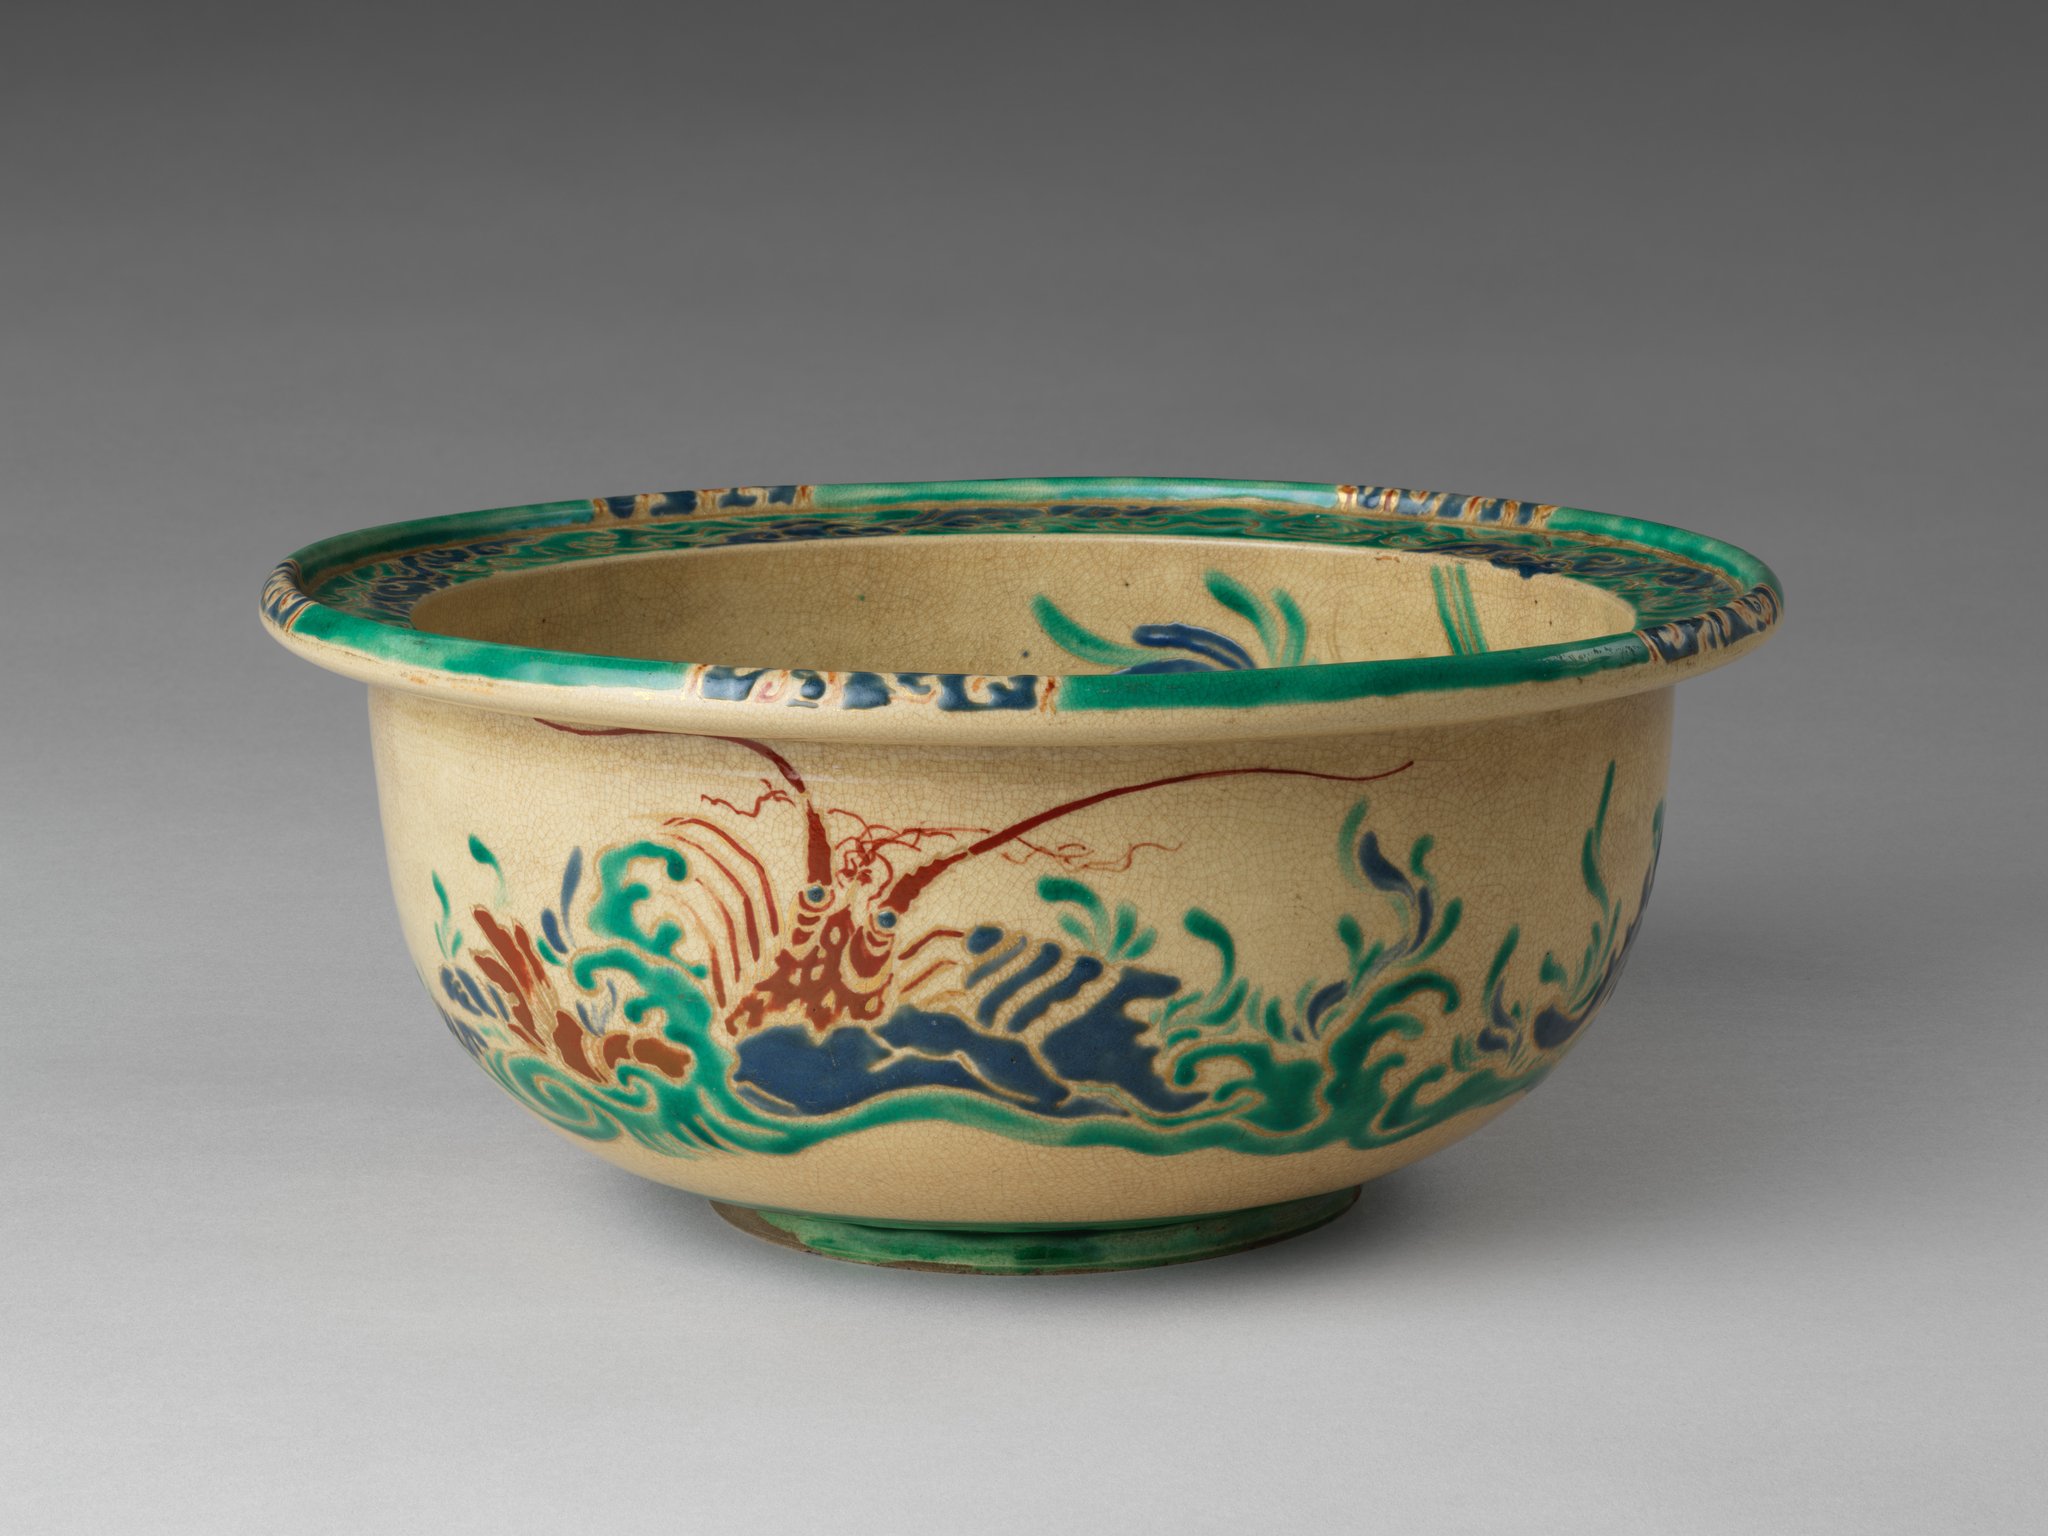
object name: bowl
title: Bowl with design of a lobster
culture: japanese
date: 1601-1700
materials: earthenware, glaze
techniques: polychrome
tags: lobsters